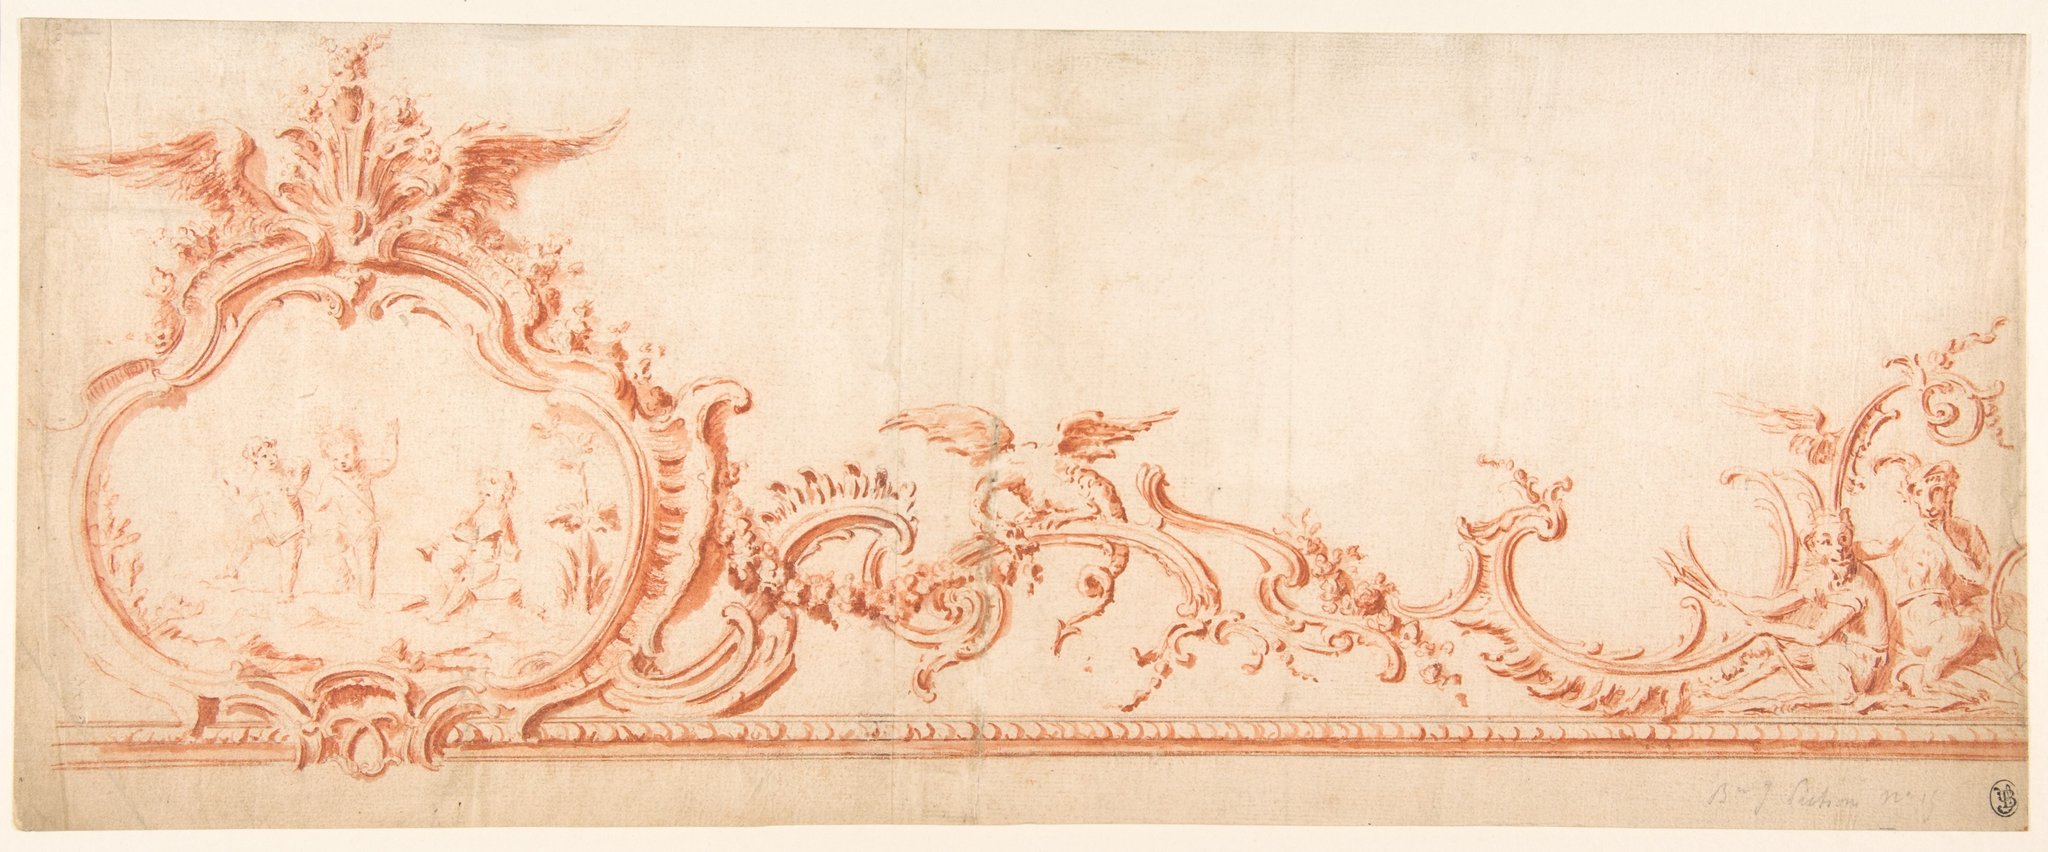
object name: drawing ornament architecture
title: Design for Stucco Decorations with a Cartouche at Left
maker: gilles-marie oppenord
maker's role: artist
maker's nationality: french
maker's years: 1672-1742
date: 1725-1740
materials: chalk, graphite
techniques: drawing, wash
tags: birds,cartouches,ornament,putti,monkeys